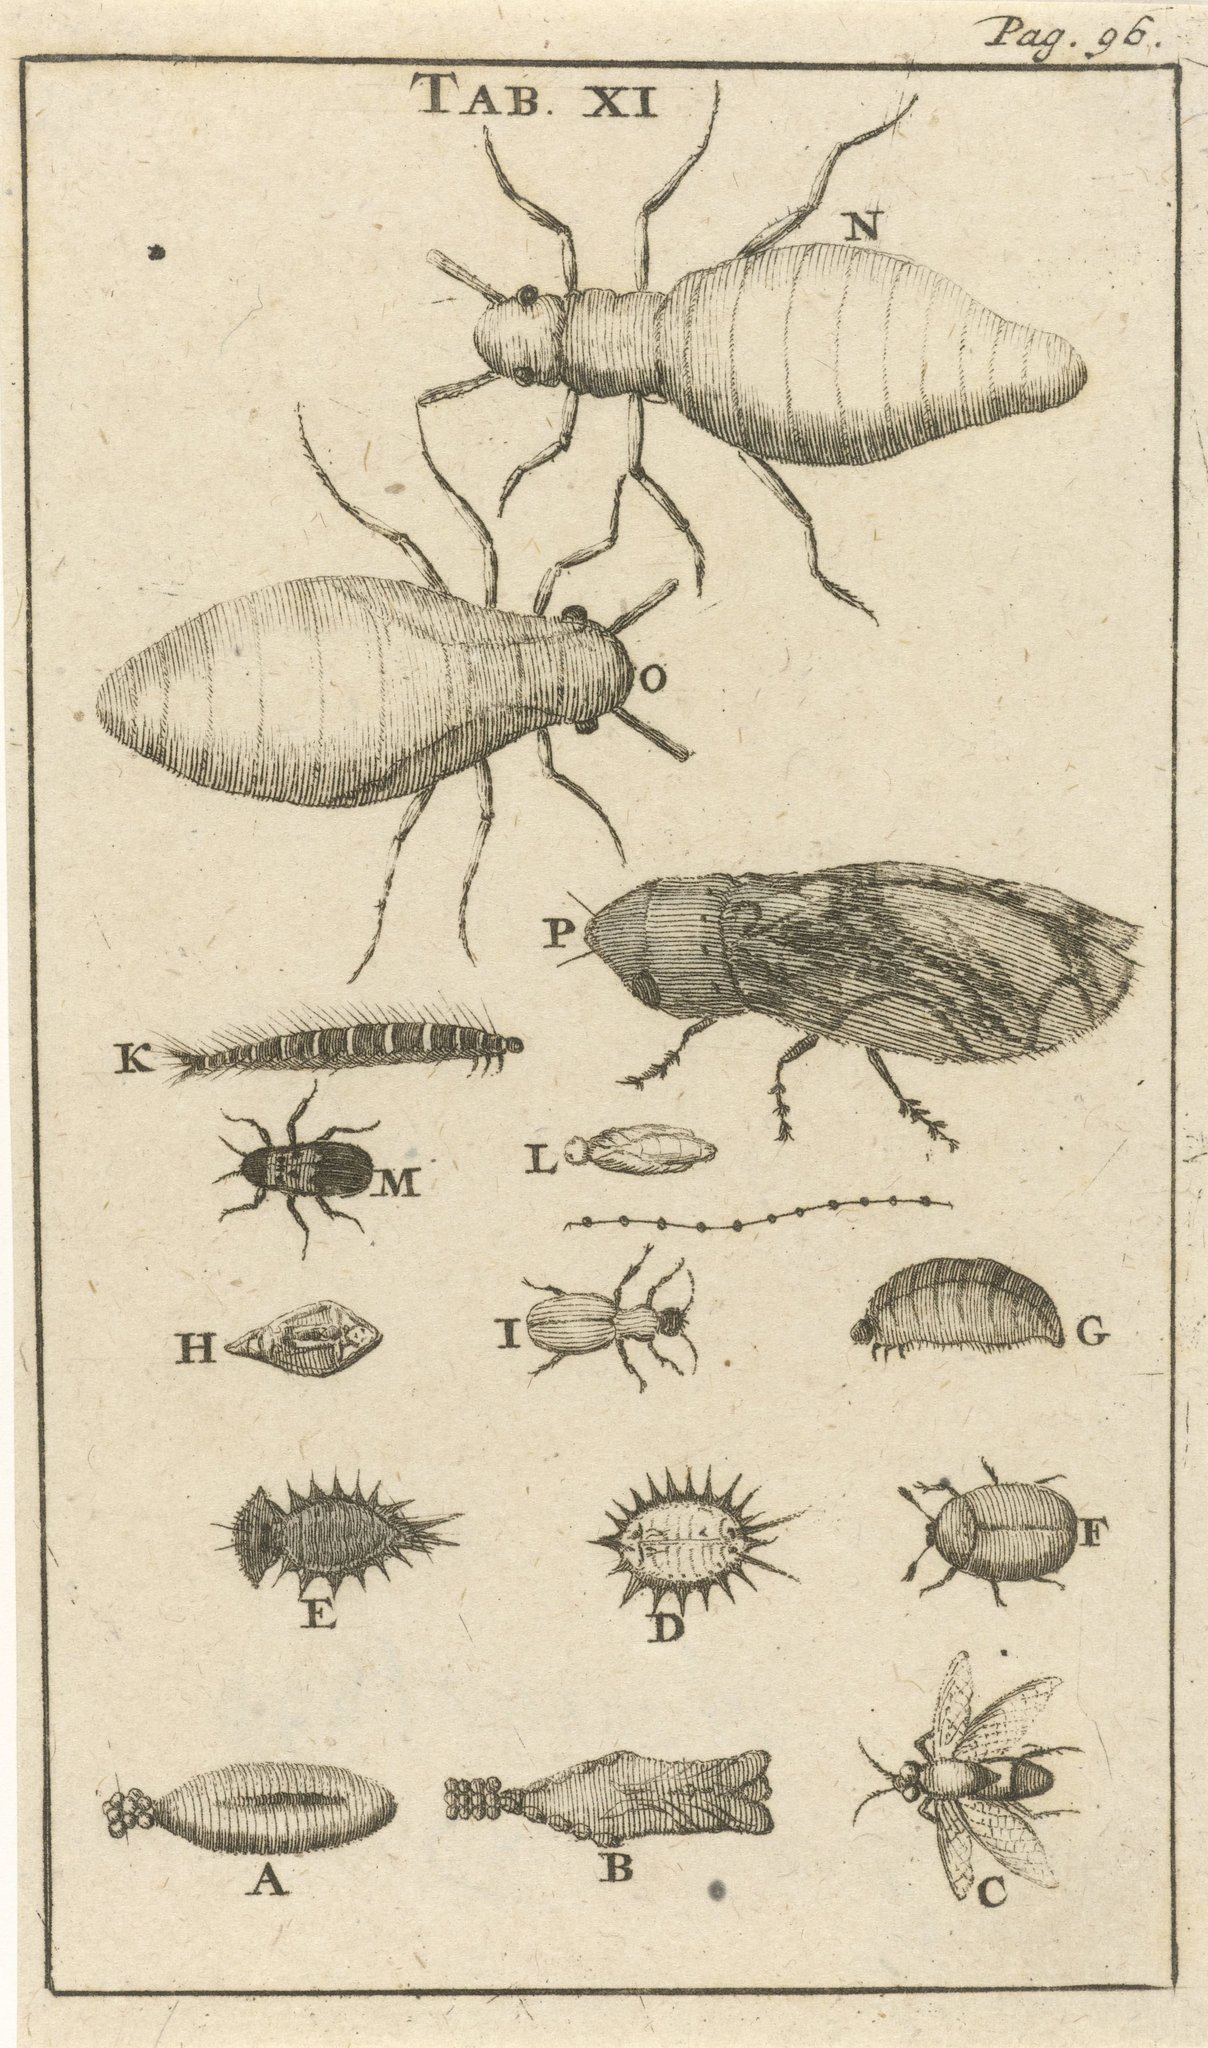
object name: print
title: Kleine insecten XI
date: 1680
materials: paper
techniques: etching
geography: amsterdam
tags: insects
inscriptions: collector's mark: Lugt 2228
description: Illustratie opgenomen in: Blankaart, Steven. Schou-burg der rupsen, wormen, ma'den, en vliegende dierkens daar uit voortkomende. Amsterdam: Jan Claesz ten Hoorn, 1680.